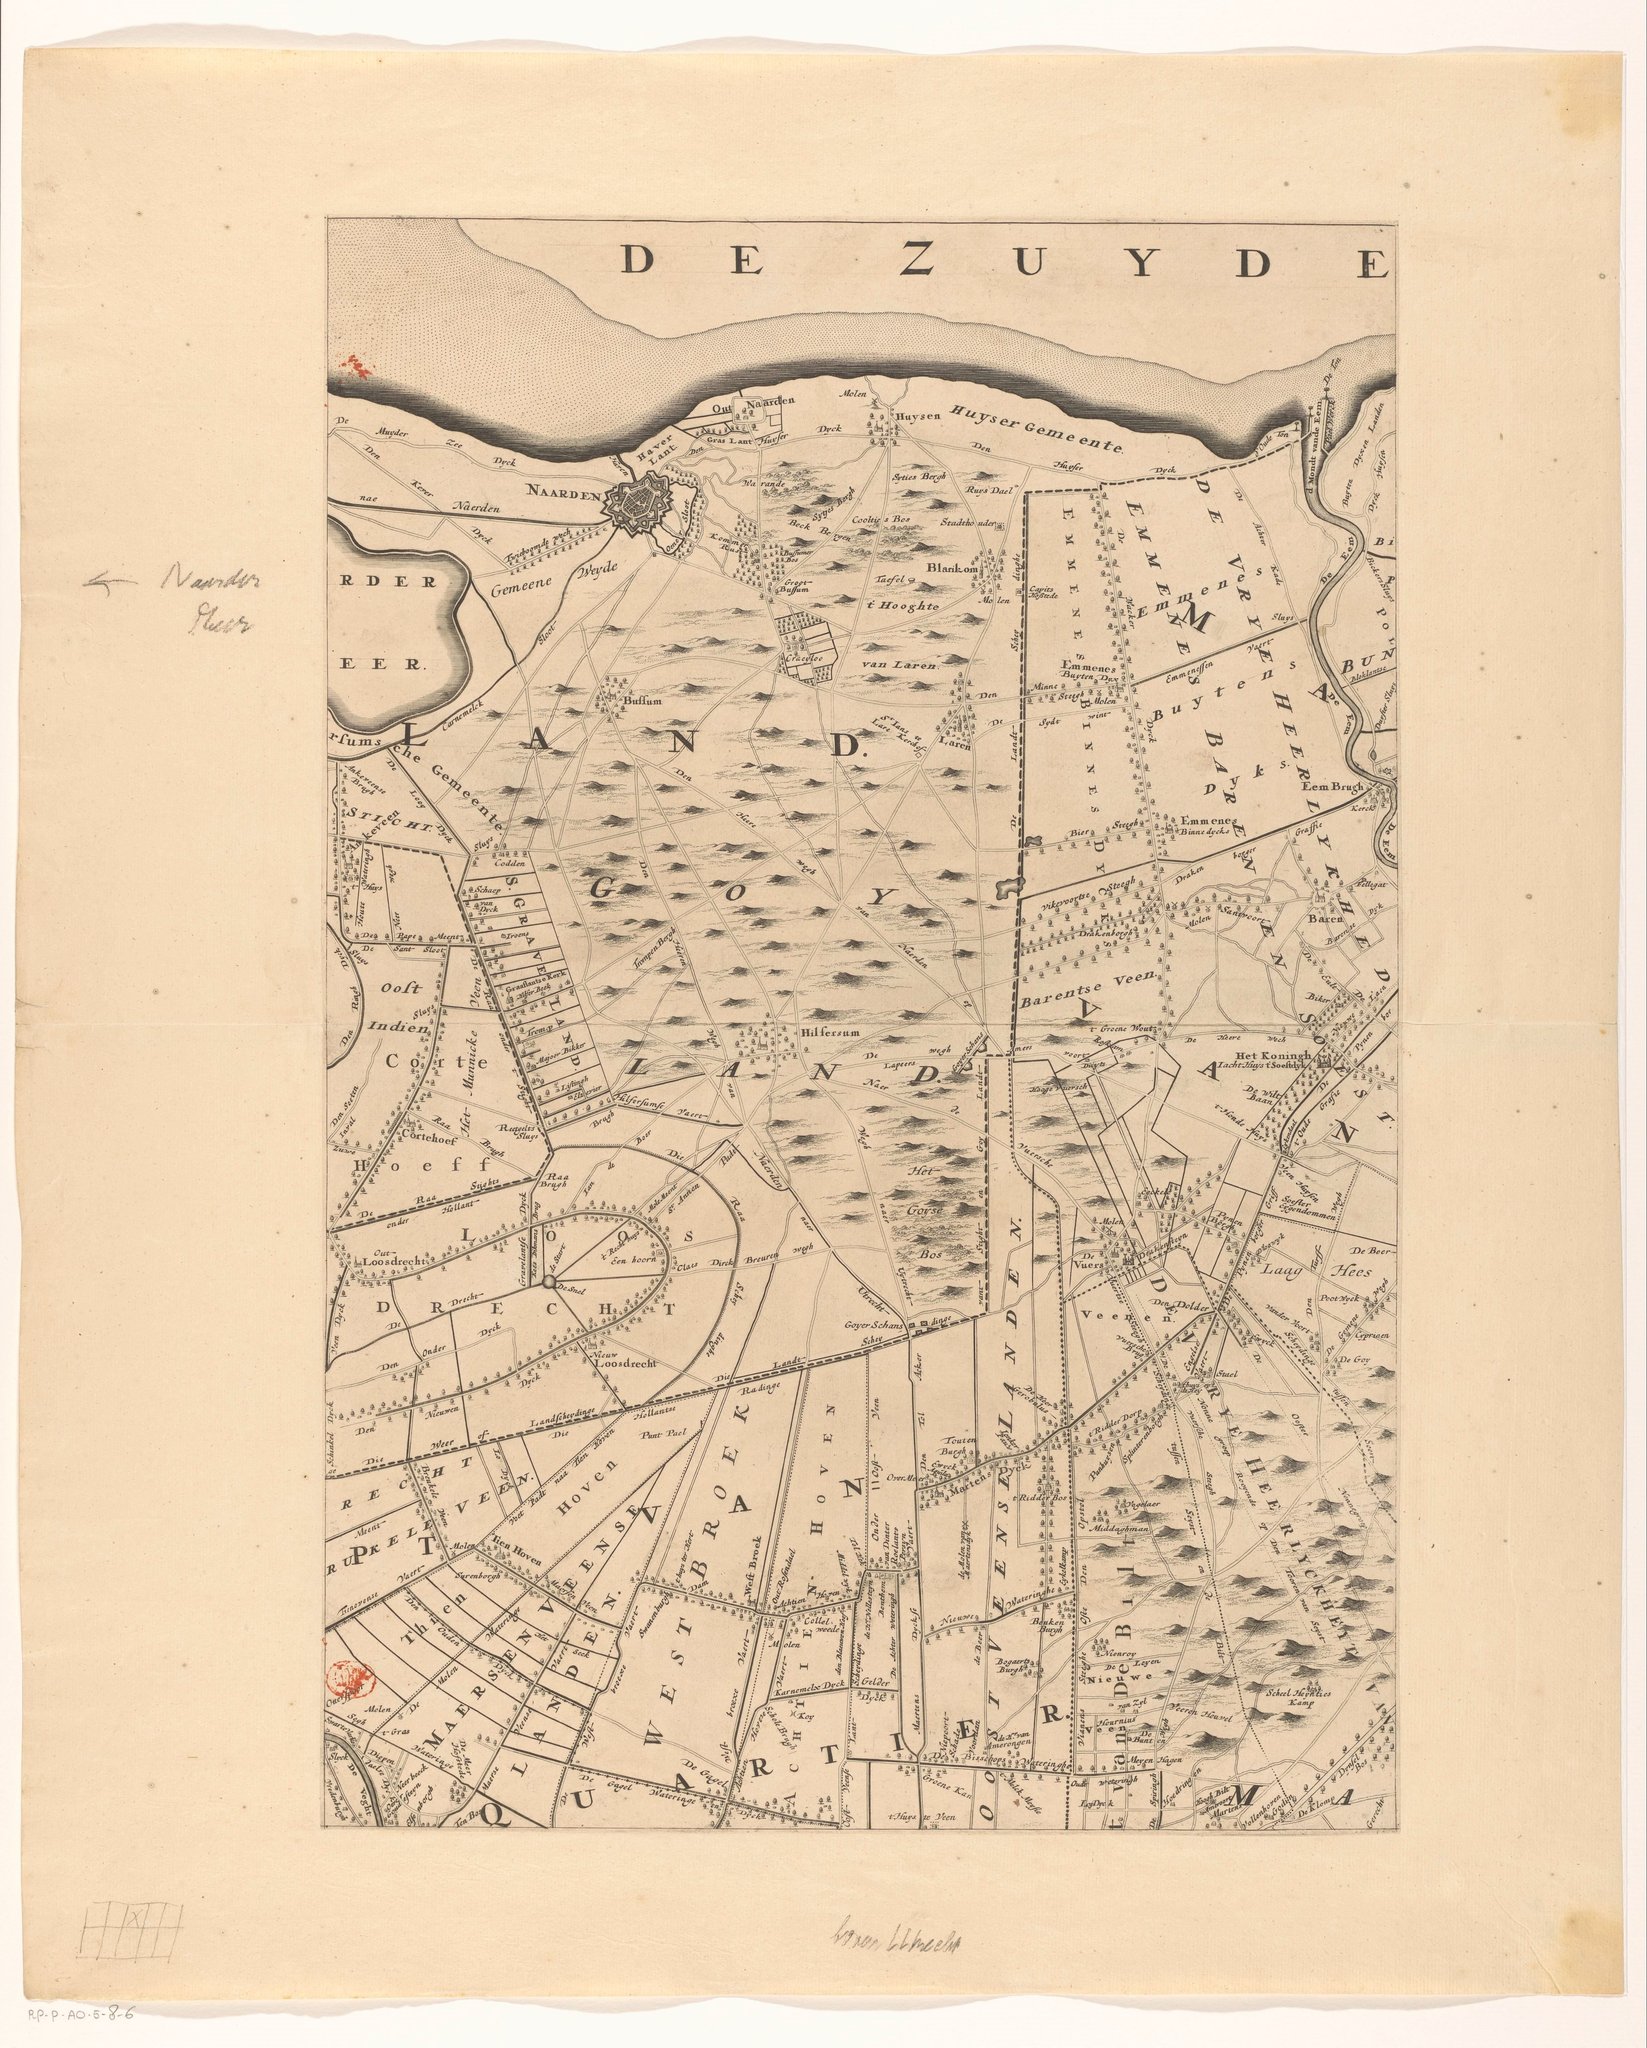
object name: map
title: Nieuwe kaart van den lande van Utrecht (...)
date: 1696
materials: paper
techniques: engraving, etching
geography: amsterdam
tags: maps of separate countries or regions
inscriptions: collector's mark: Lugt 195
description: In de literatuur is altijd verondersteld dat er vier staten van deze kaart bestonden en dat de gewijzigde titel en inhoud van de titelcartouche, advertentie onder de cartouche, schaalstok links van de cartouche en andere wijzigingen op de kaart op de veronderstelde tweede staat in 1743 zouden zijn aangebracht door Covens & Mortier. Het huidige exemplaar is echter een tot dusver onbekende tussenstaat die niet alleen aantoont dat de genoemde veranderingen eerder zijn aangebracht, maar ook dat deze tweede staat is uitgegeven door Nicolaes Visscher II, de uitgever van de eerste staat.